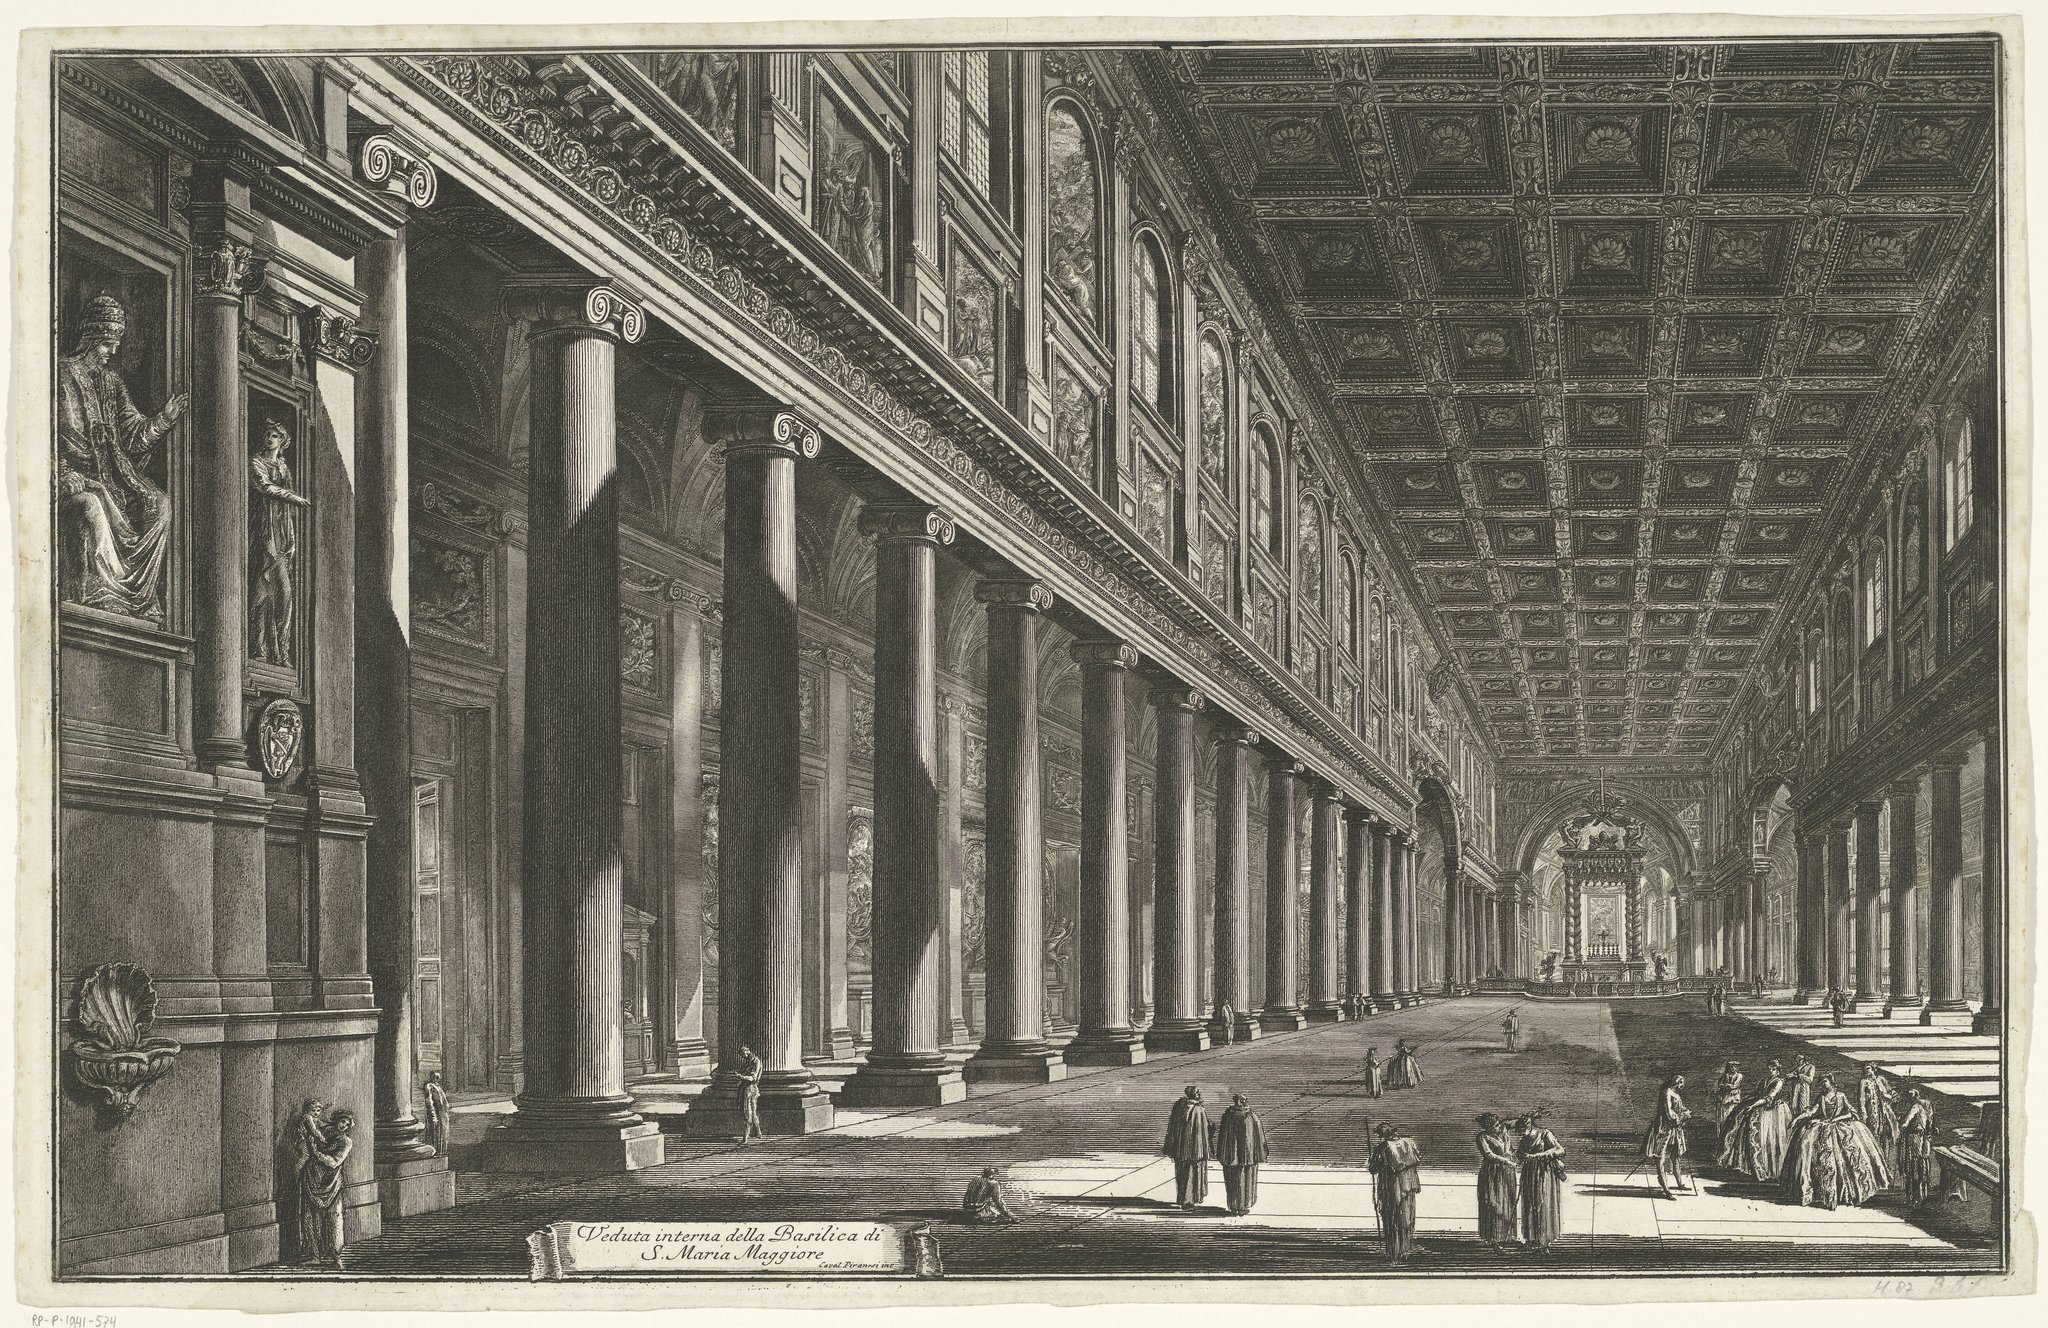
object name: print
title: Veduta interna della Basilica di S. Maria Maggiore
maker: giovanni battista piranesi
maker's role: designer, draughtsman, print maker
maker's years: 1720-1778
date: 1748-1778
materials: paper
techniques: etching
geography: rome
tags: roman catholic church, interior of church, rome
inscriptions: collector's mark: Lugt 2228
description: Deze prent maakt deel uit van de serie 'Vedute di Roma'. Piranesi werkte aan deze 135 platen tellende serie tussen 1748 en zijn dood in 1778. Francesco Piranesi voegde later nog twee prenten toe aan de reeks van zijn vader.